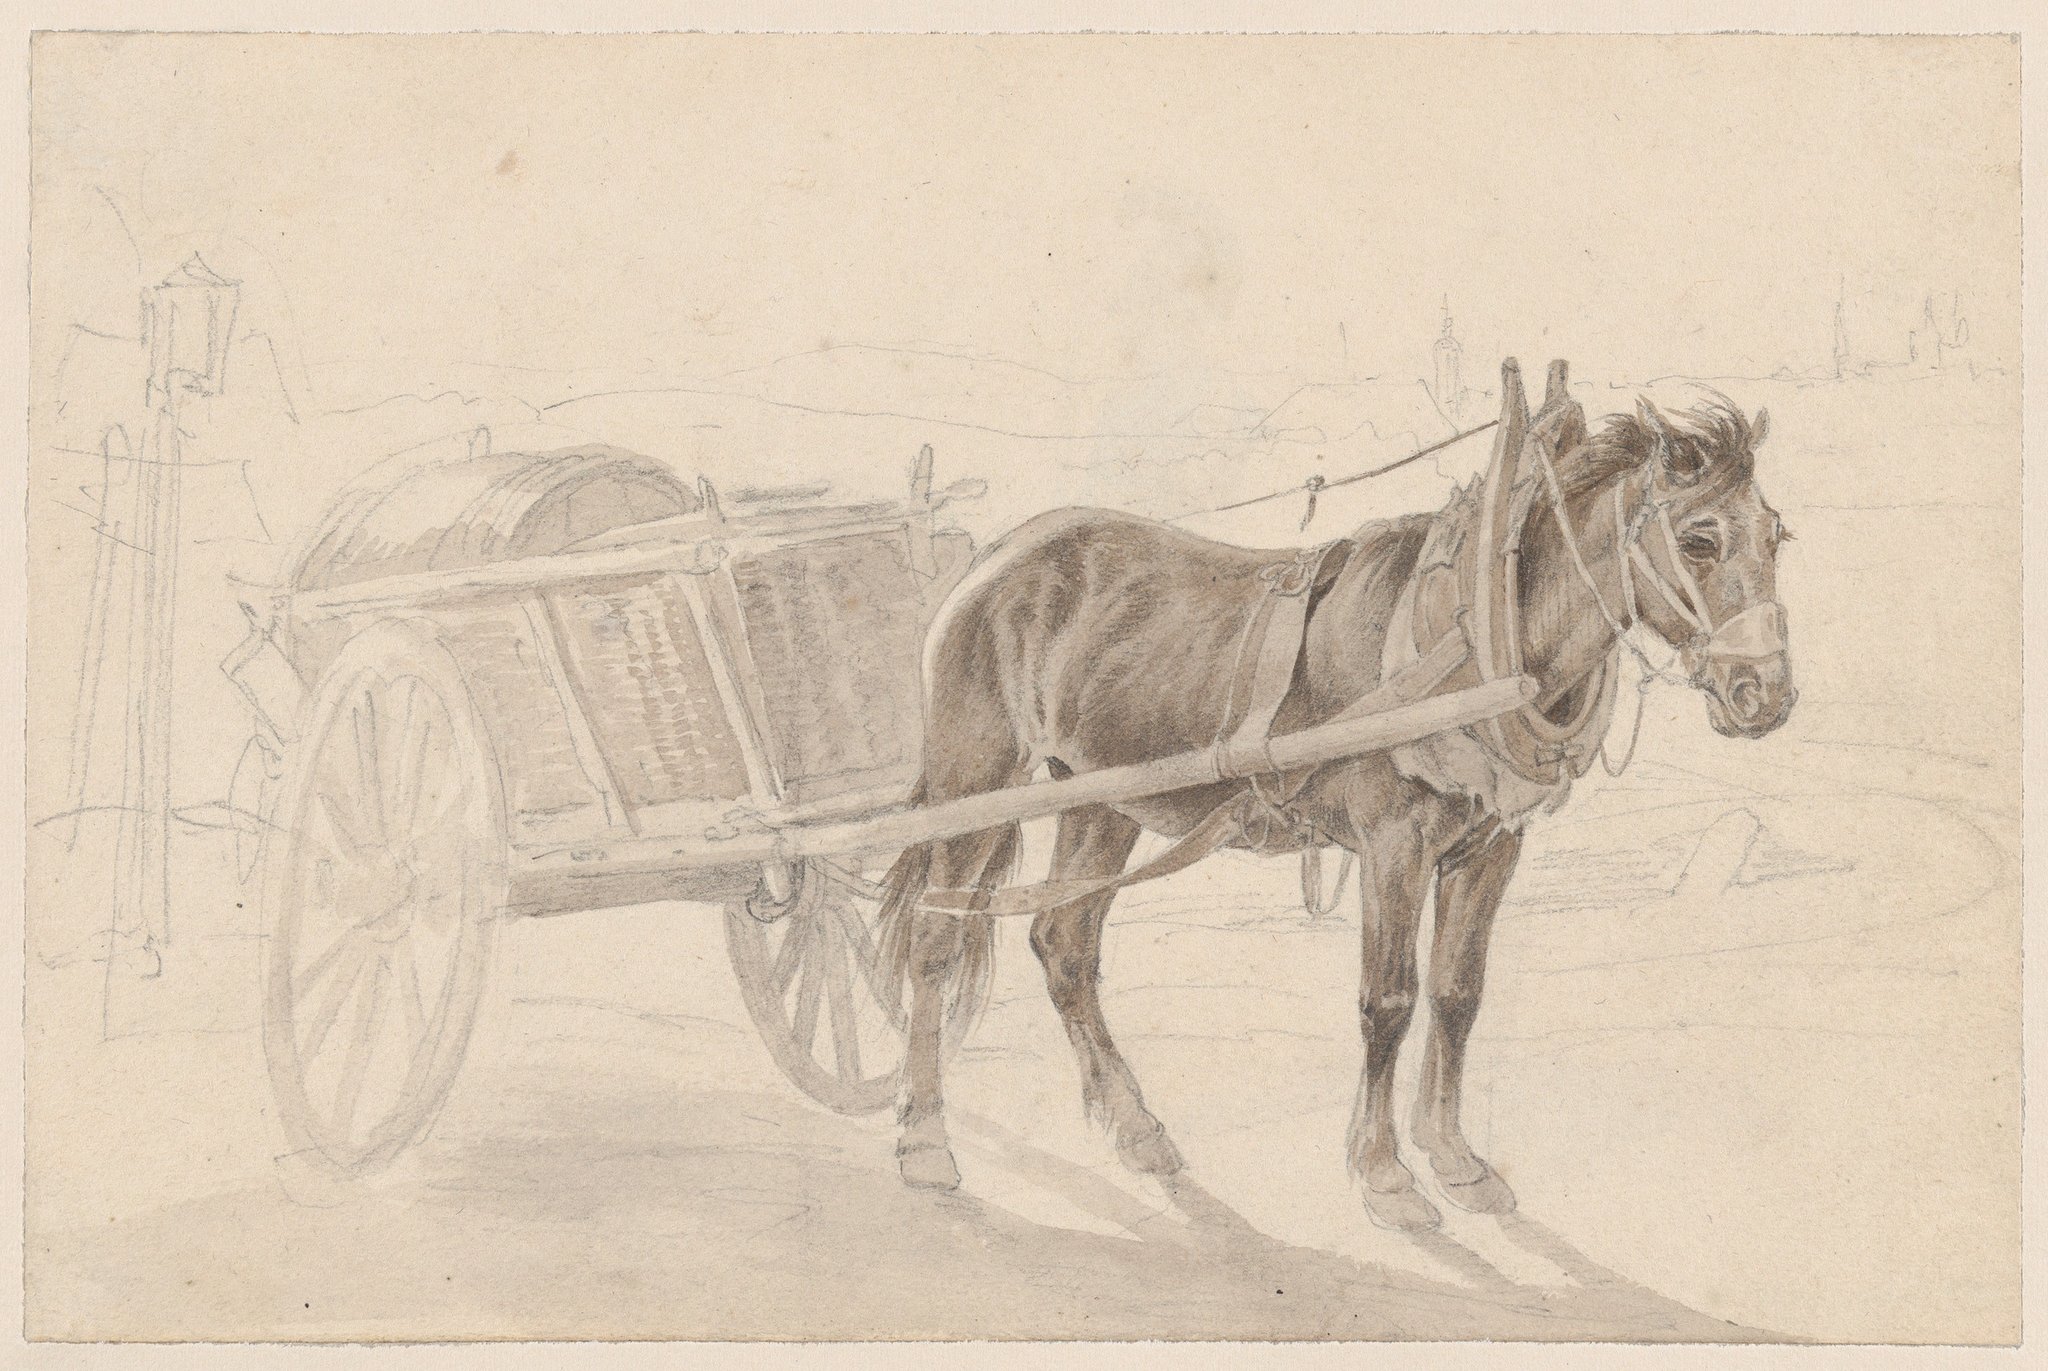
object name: drawing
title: A Cart Drawn by a Brown Horse Near a Lamp Pole; Verso: A Group of Mounted Officers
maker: johann adam klein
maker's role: artist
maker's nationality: german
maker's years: 1792-1875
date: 1815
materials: graphite, watercolor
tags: horses,carts